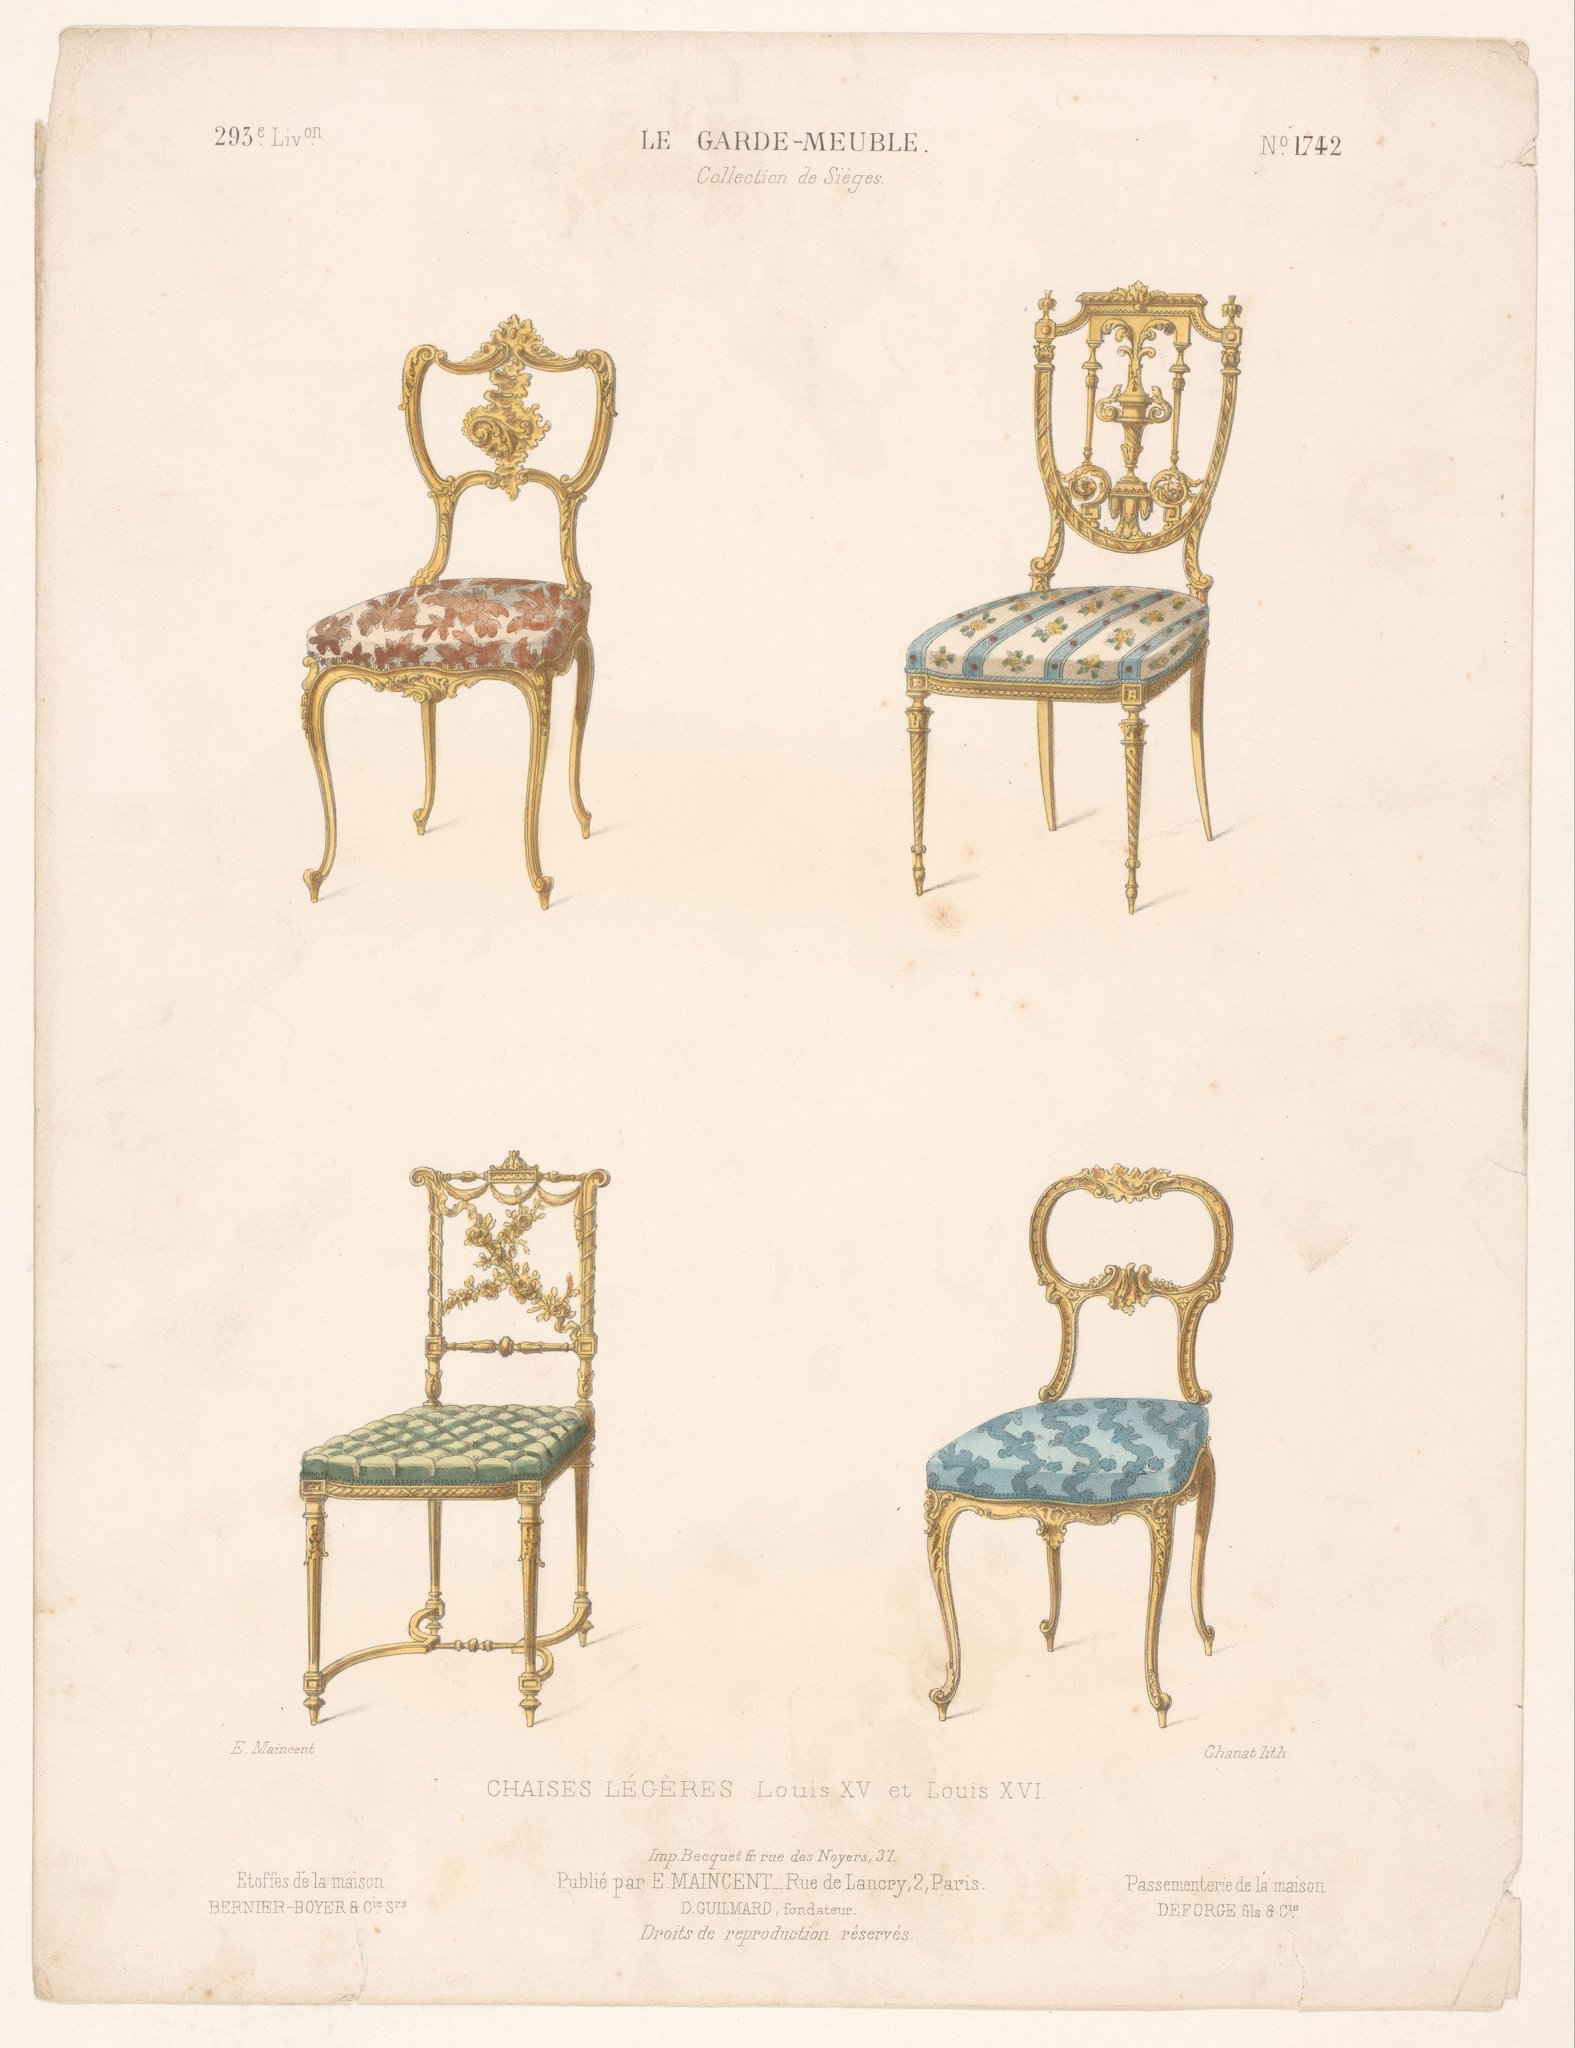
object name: print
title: Le garde-meuble / Collection de Sièges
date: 1885-1895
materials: paper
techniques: hand coloring, lithograph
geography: paris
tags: seating furniture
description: Ieder Livraison in de serie Le Garde-Meuble bevat negen platen: drie 'sièges' (zitmeubels), drie 'meubles' (diverse meubels zoals tafels en kasten) en drie 'tentures' (gordijnen en draperieën).